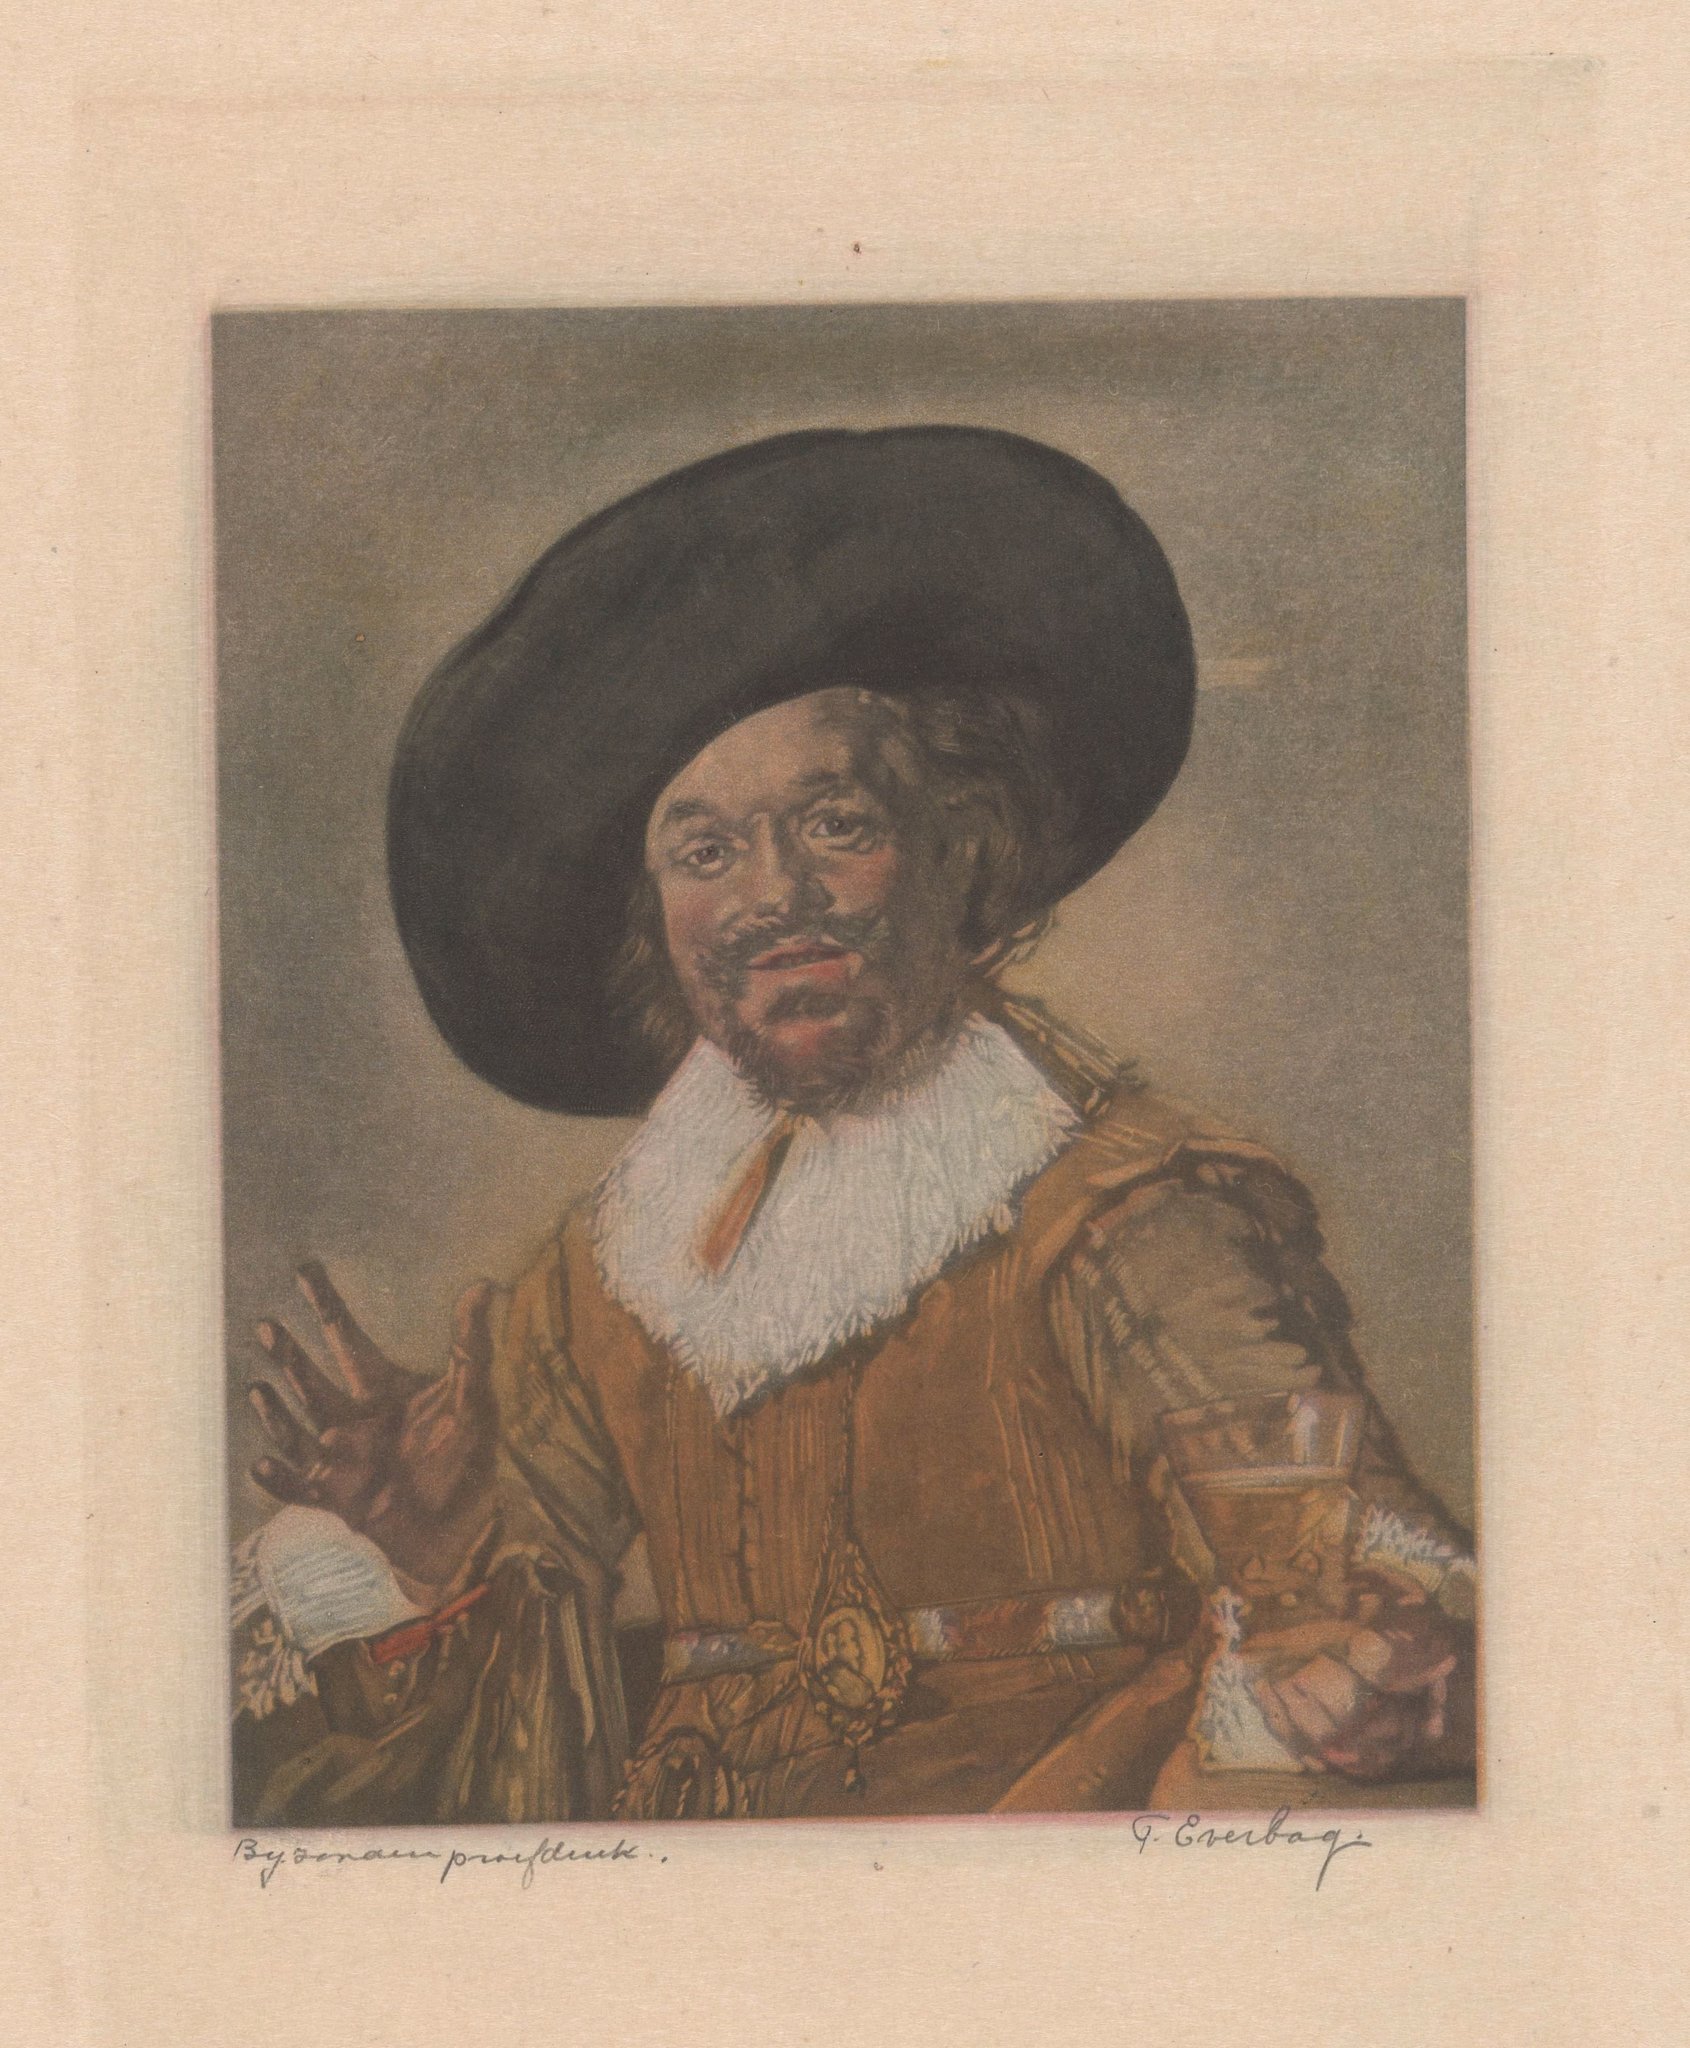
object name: print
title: Vrolijke drinker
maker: frans everbag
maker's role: draughtsman, print maker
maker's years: 1877-1947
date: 1887-1914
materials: paper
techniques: aquatint, etching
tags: laughing, warfare; military affairs (+ citizen soldiery, civil guard, citizen militia), head-gear: hat, glass, rummer, drinking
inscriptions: collector's mark: Lugt 2233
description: Een lachende man met baard en hoed, met een berkenmeier in de linkerhand en opgeheven rechterhand. Om de hals een medaillon aan een ketting.